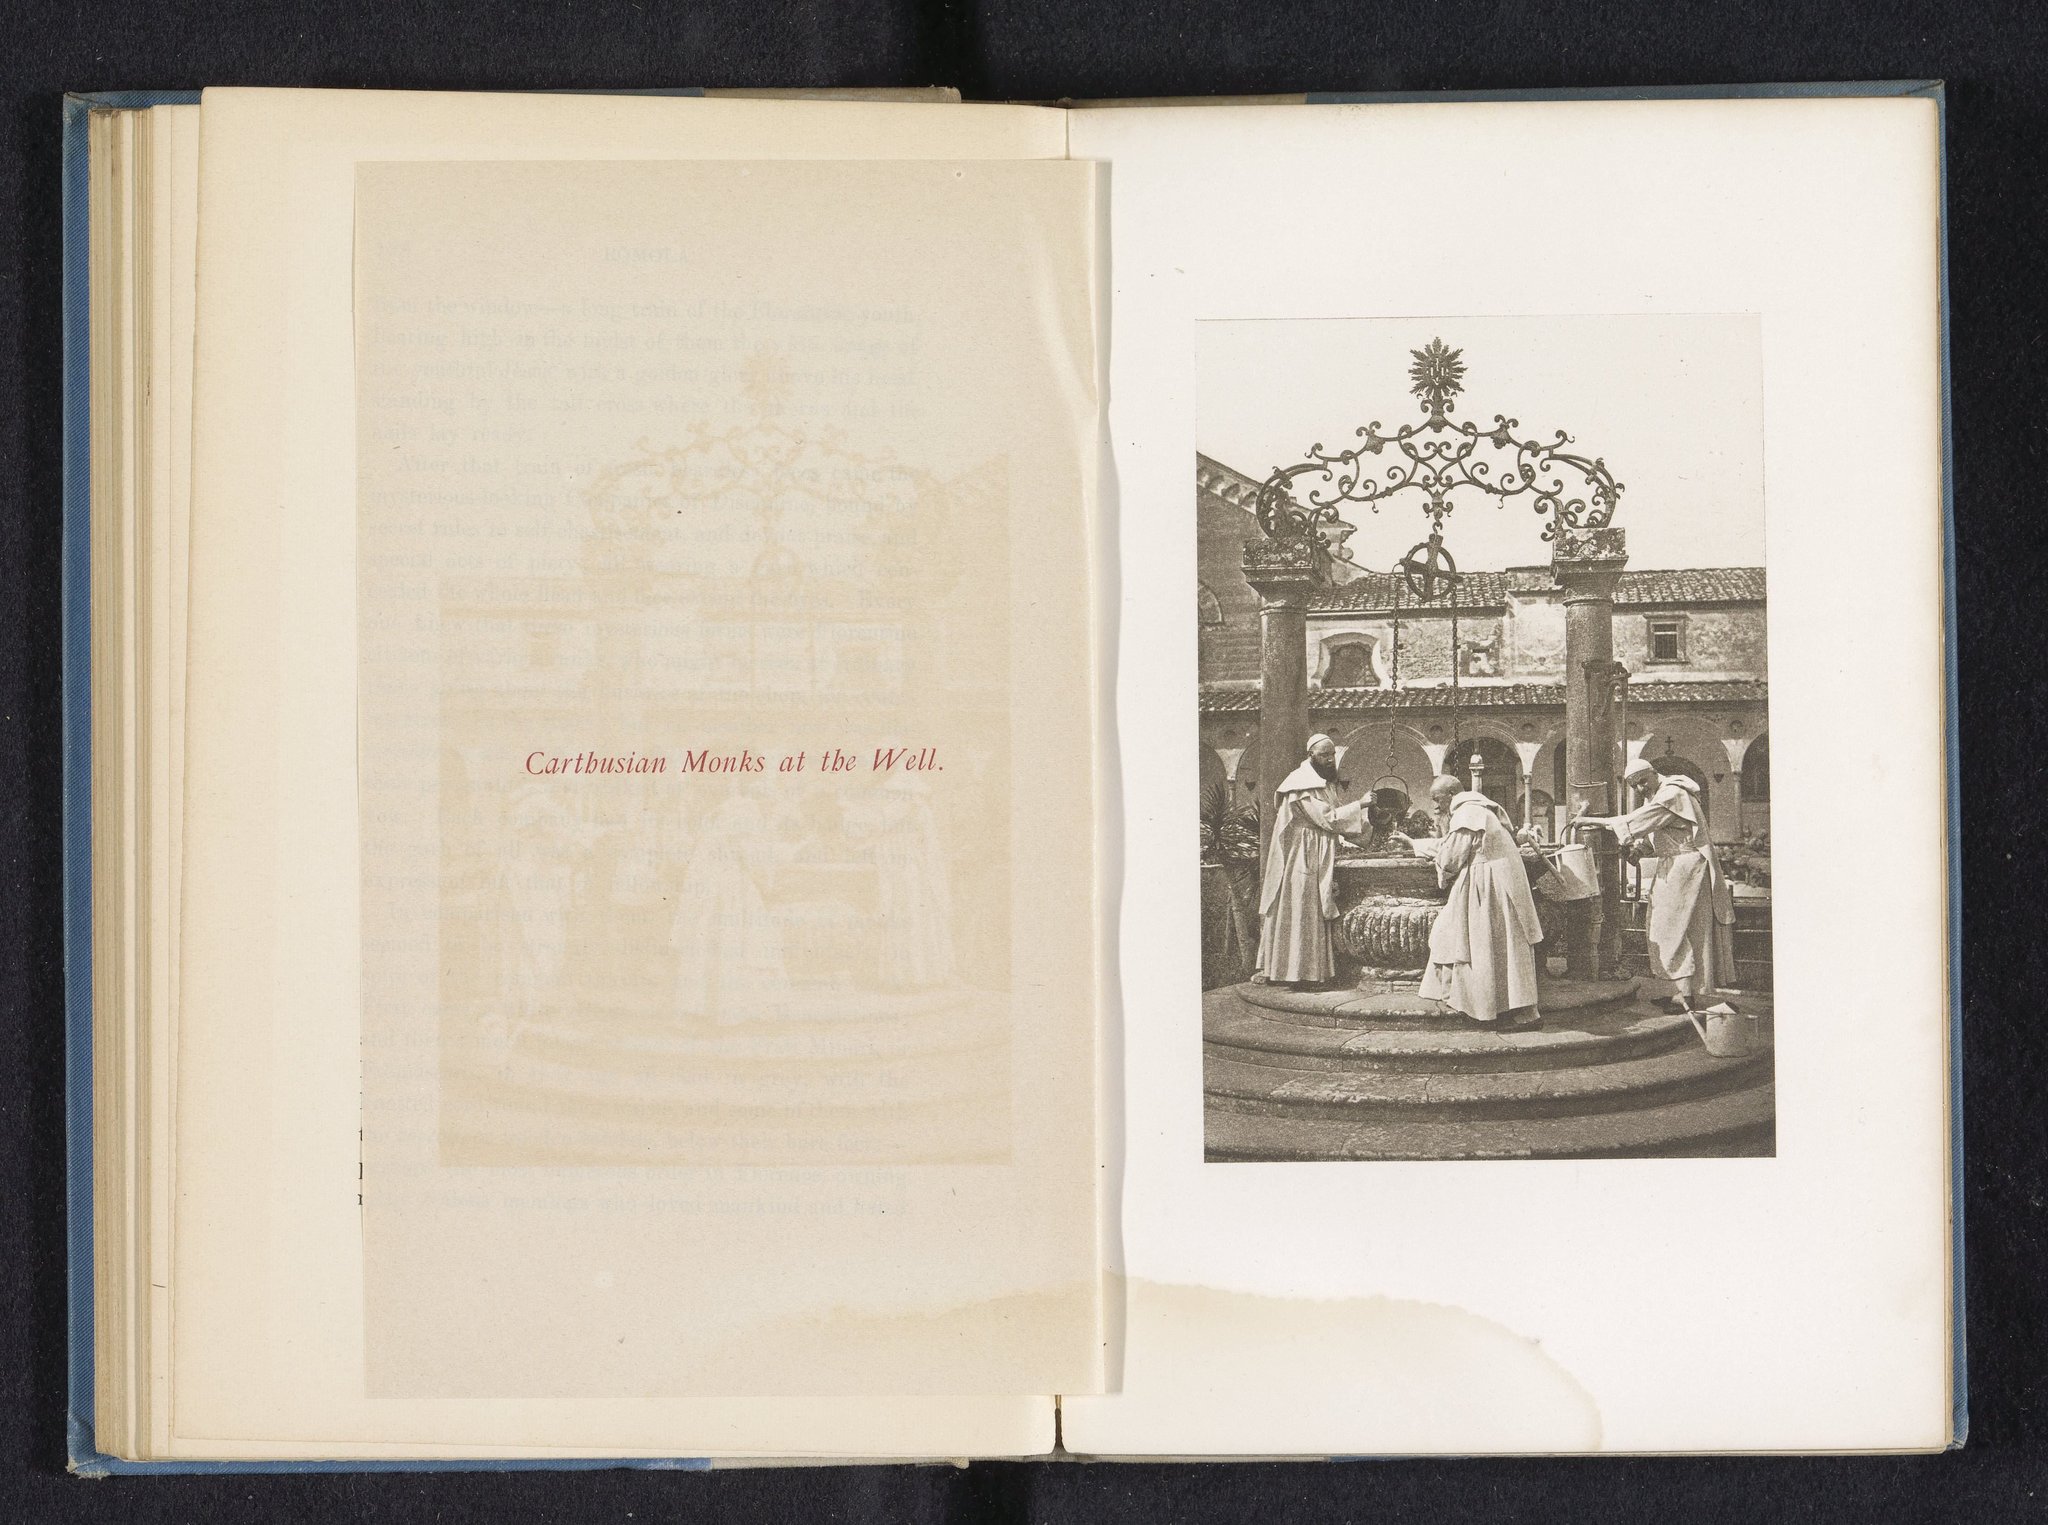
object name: photomechanical print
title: Kartuizer monniken voor een put te Florence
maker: Anonymous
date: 1880-1890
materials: paper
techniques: photoaquatint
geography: florence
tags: well, monastic orders, monastic life: carthusians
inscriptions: title: ‘Carthusian Monks at the Well.’